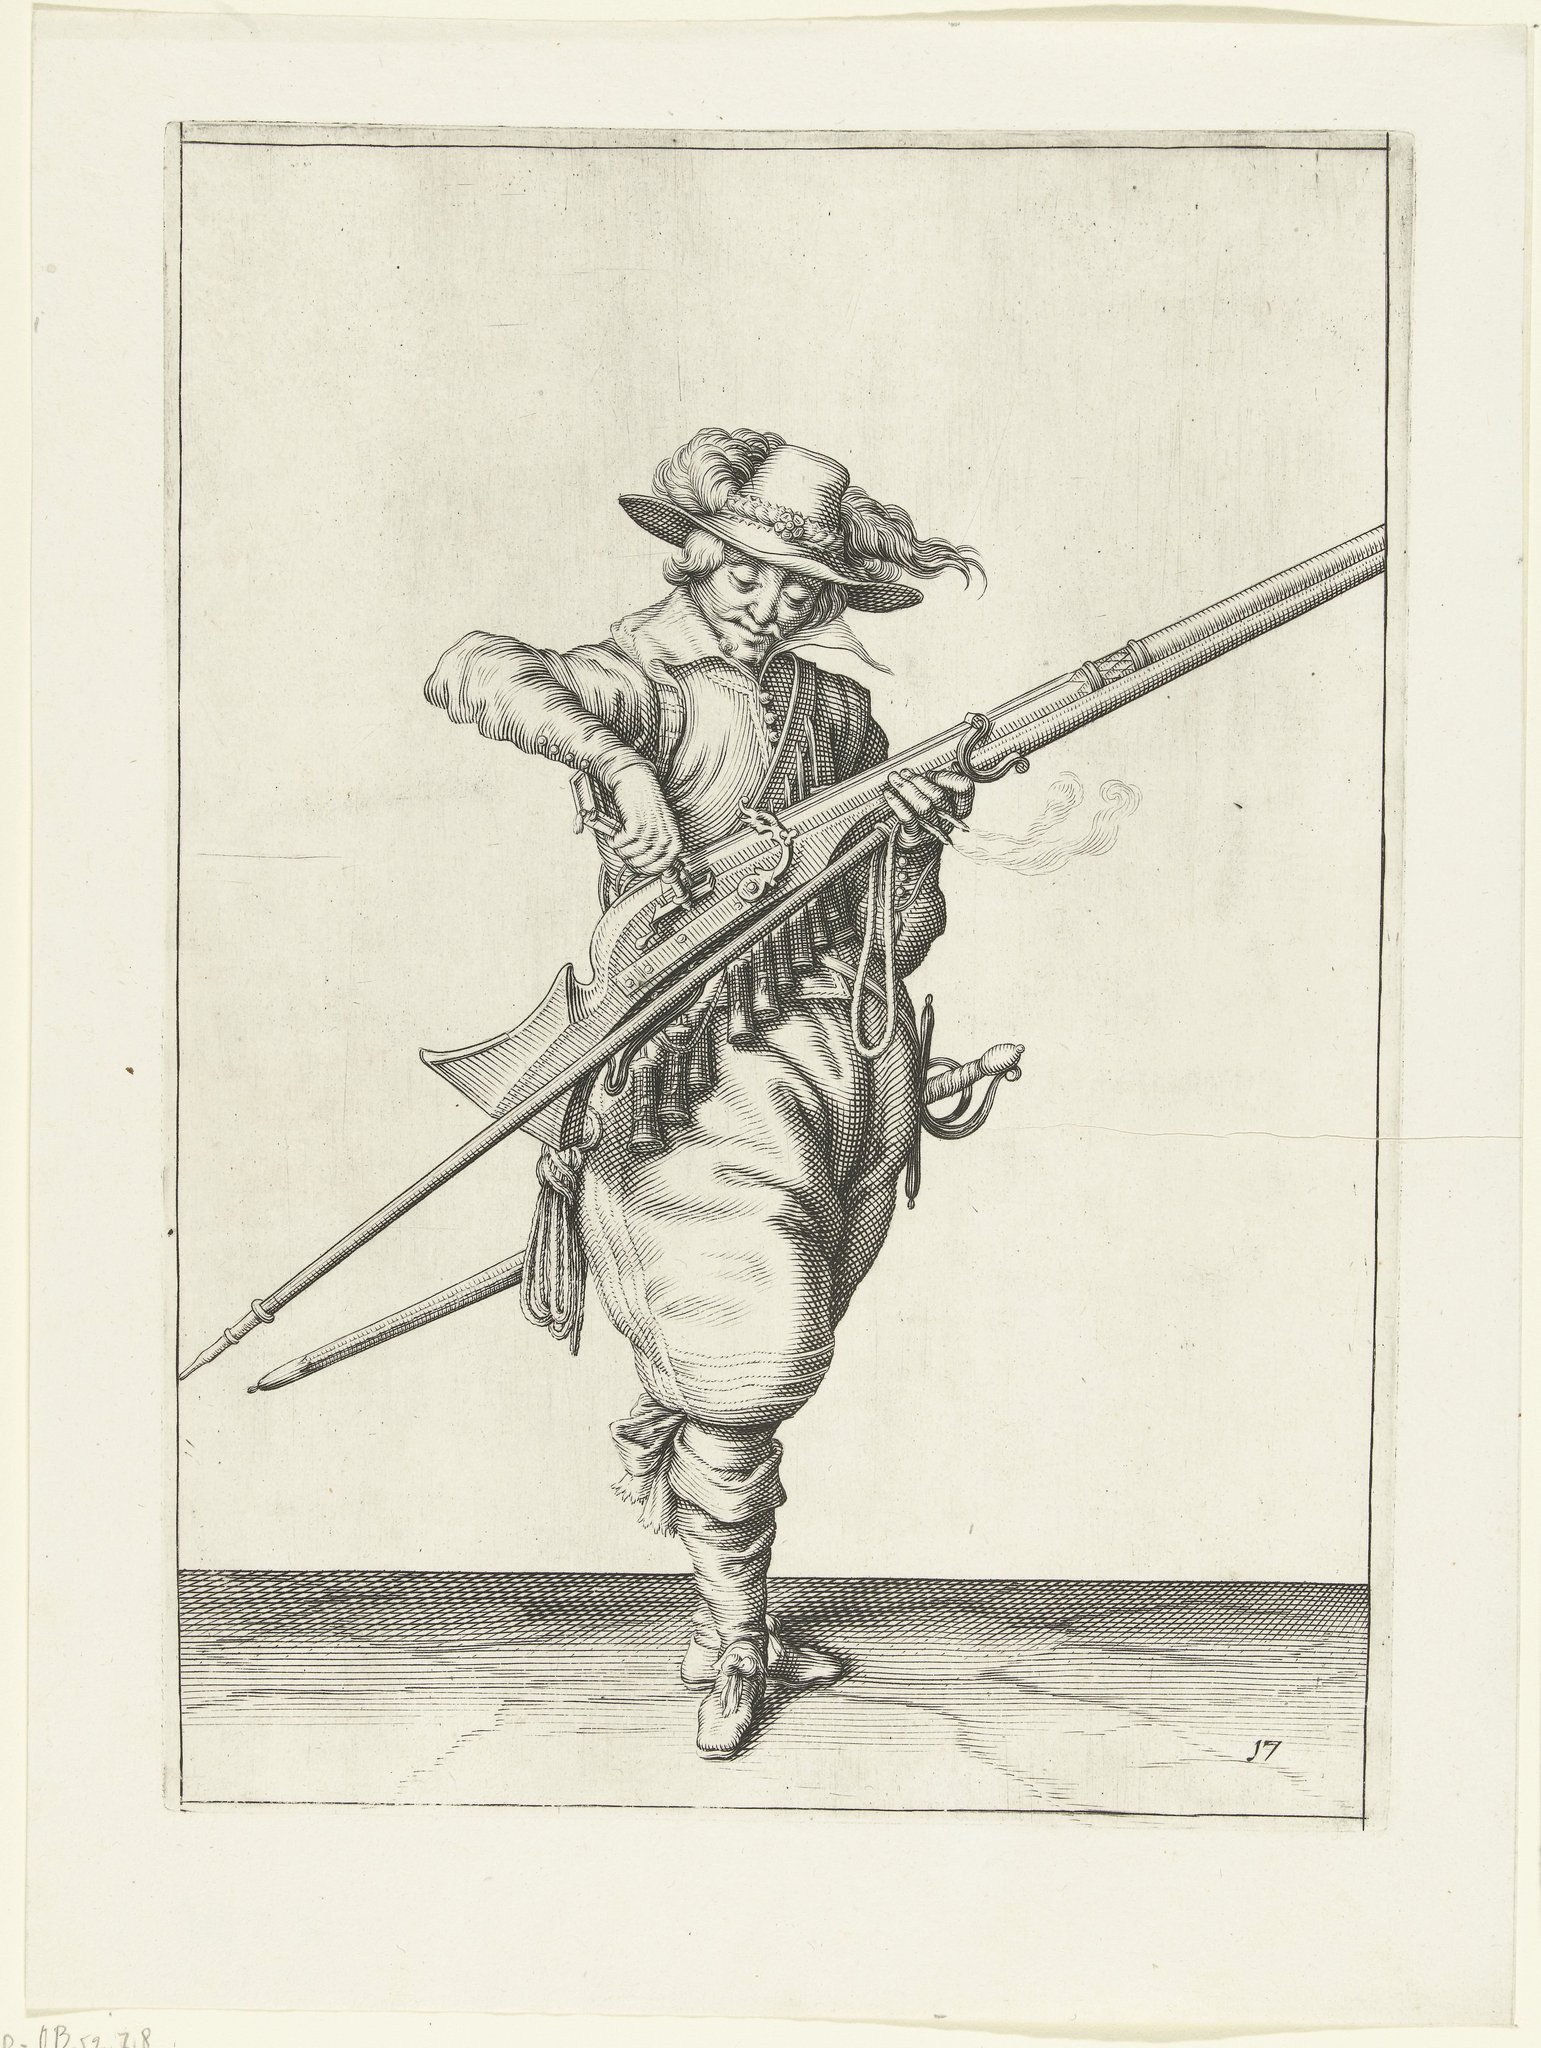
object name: print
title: Soldaat die kruit in de pan van zijn musket giet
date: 1597-1607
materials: paper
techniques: engraving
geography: netherlands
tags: manoeuvre ~ military training, firearms: rifle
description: Een soldaat, ten voeten uit, die kruit uit een kruitfles in de pan (het kruitreservoir) van een musket (een bepaald type vuurwapen) giet. In zijn linkerhand behalve het musket ook een furket en een brandende lont. Deze prent is onderdeel van de reeks van 43 genummerde prenten van musketiers uit de Wapenhandelinghe.